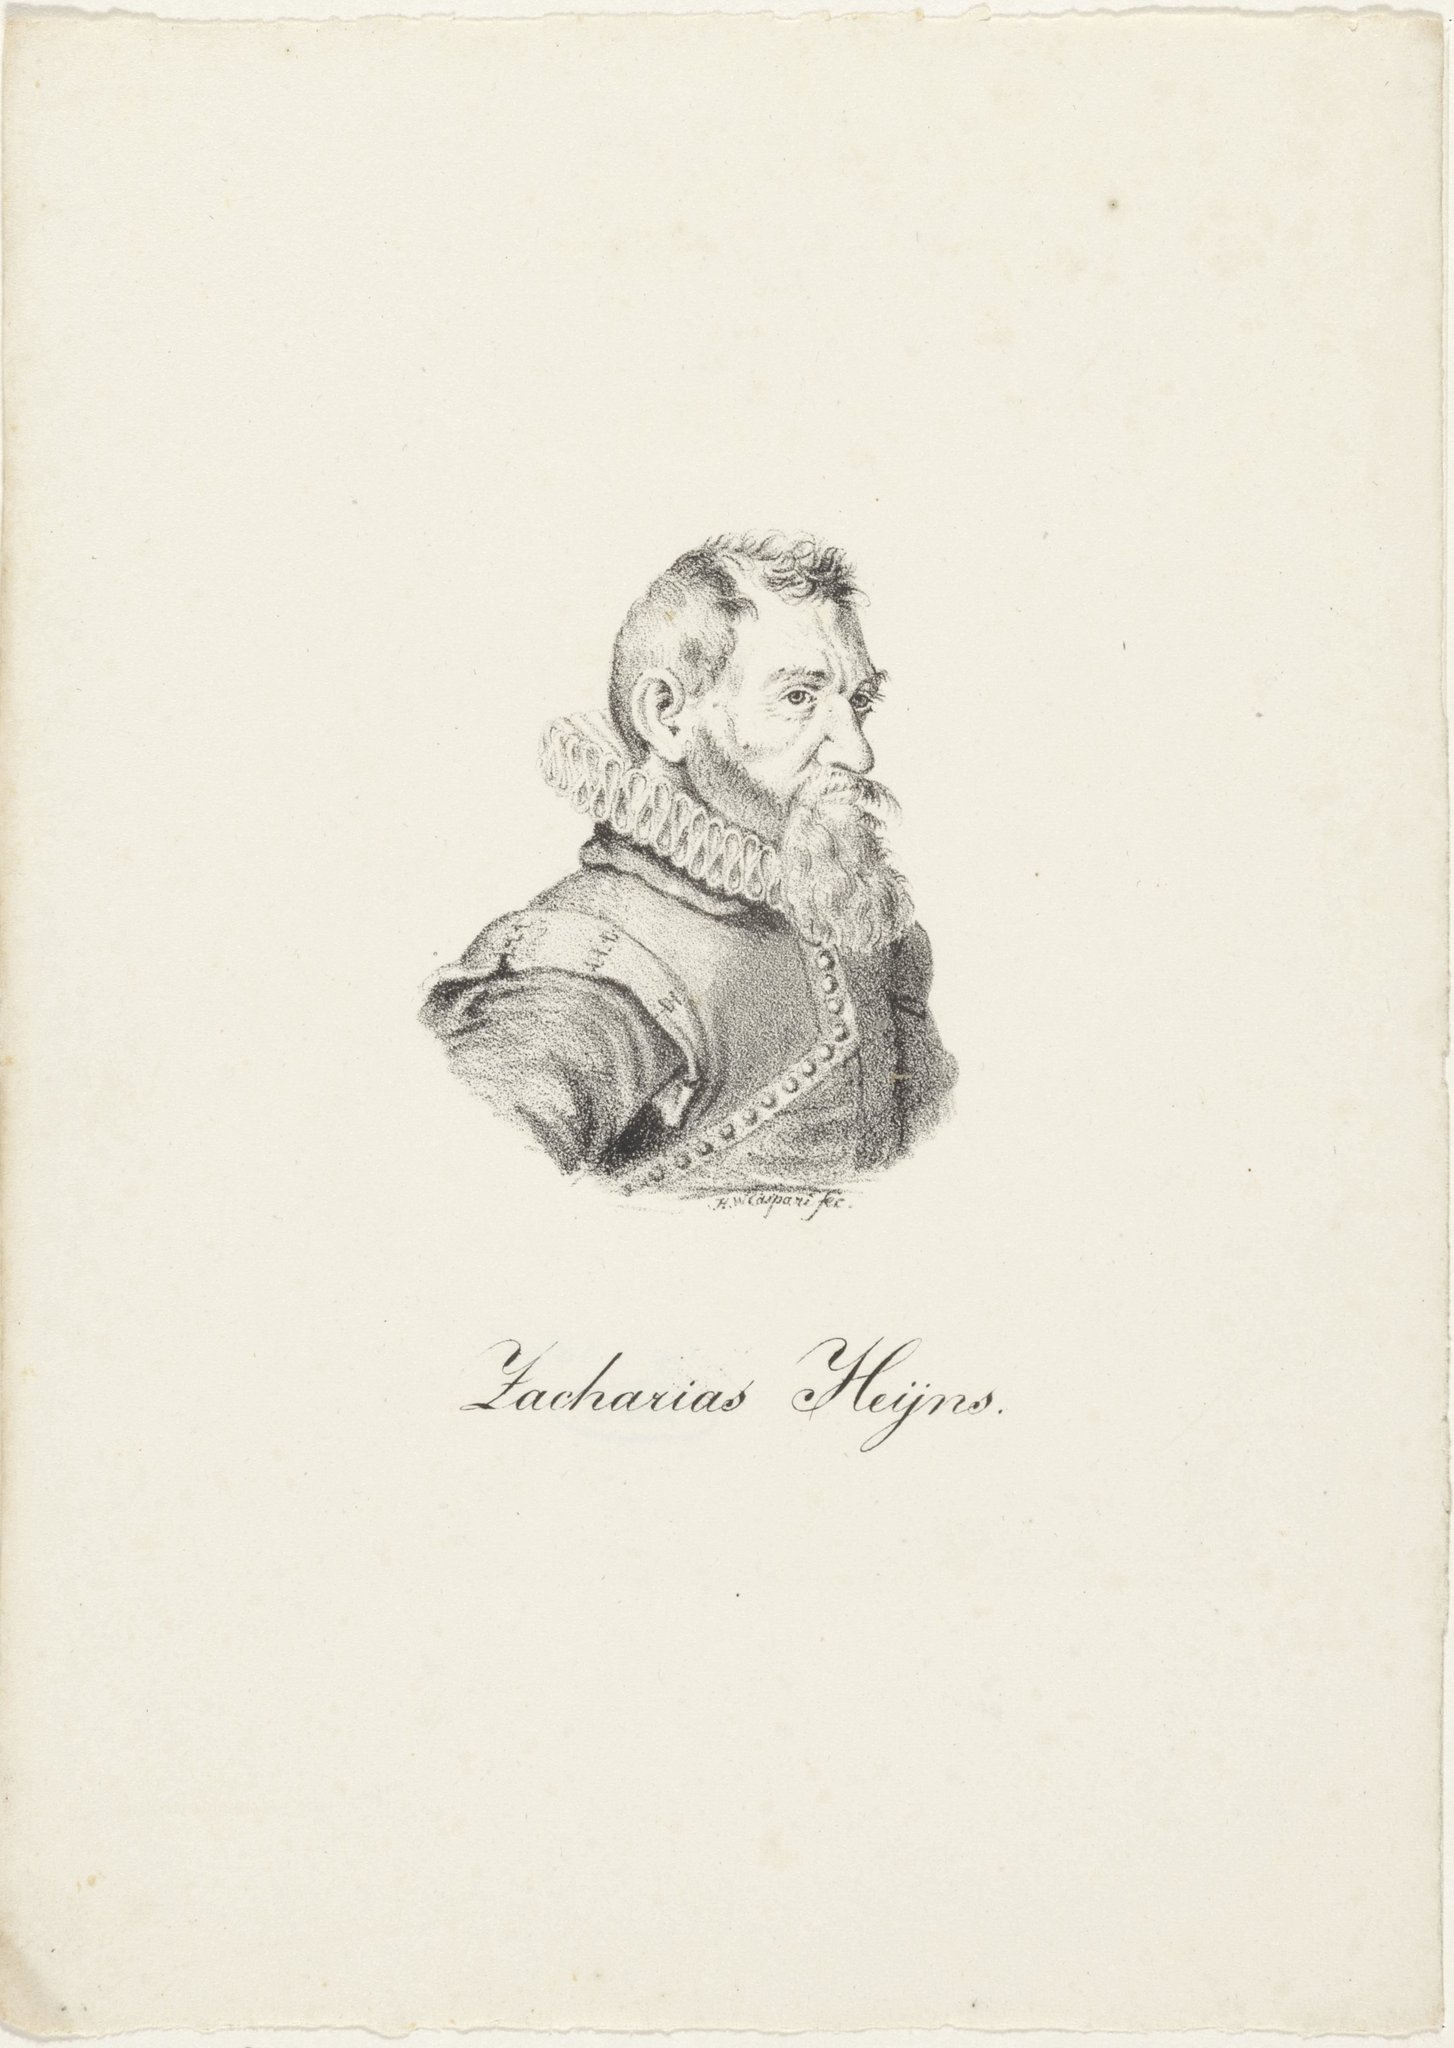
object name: print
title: Portret van Zacharias Heyns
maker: hendrik willem caspari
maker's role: draughtsman, print maker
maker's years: 1770-1829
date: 1809-1829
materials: paper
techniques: lithograph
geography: amsterdam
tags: antwerp, print maker, zacharias heyns, historical persons (+ head (and shoulders) (portrait)), neck-gear: collar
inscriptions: collector's mark: Lugt 2228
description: De geportretteerde kijkt naar rechts en draagt een lange sik en een plooikraag. Onder het portret zijn naam.